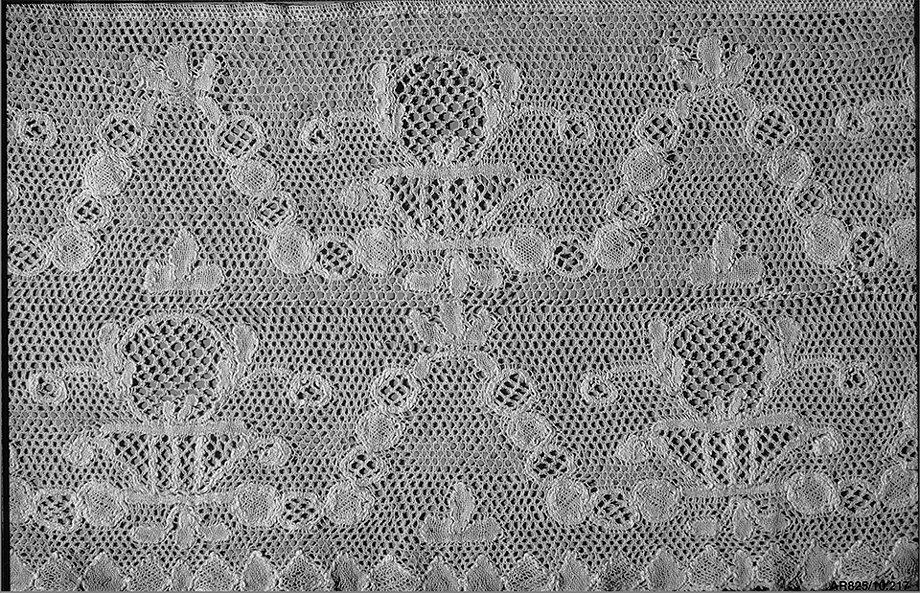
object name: piece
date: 1701-1800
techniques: lace